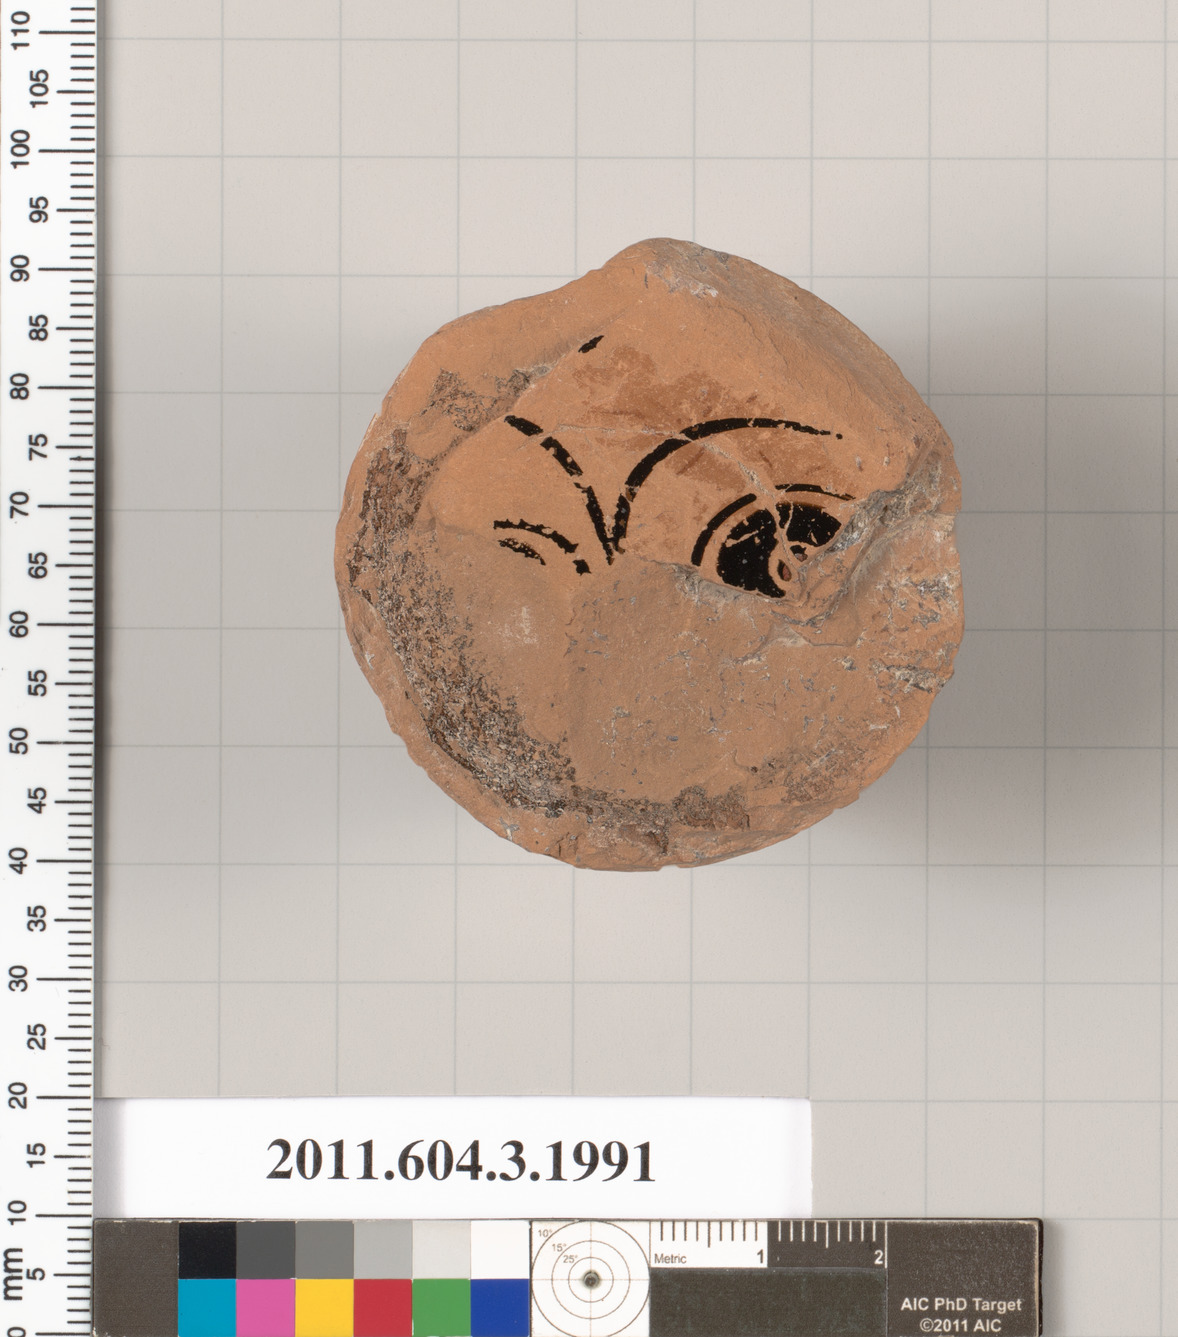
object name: kylix fragment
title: Terracotta fragment of a kylix (drinking cup)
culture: greek, attic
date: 540-530 BCE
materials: terracotta